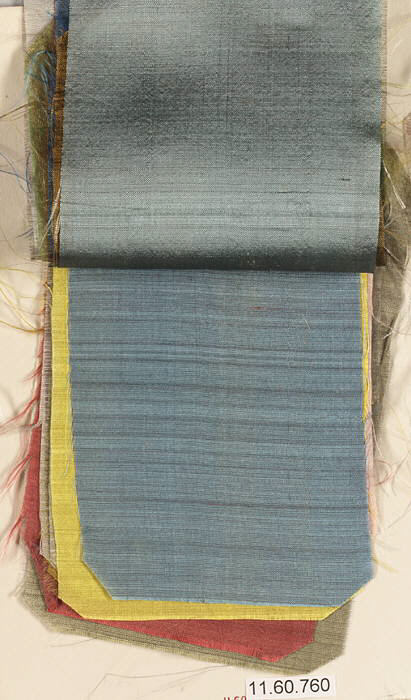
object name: sample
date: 1801-1833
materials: silk